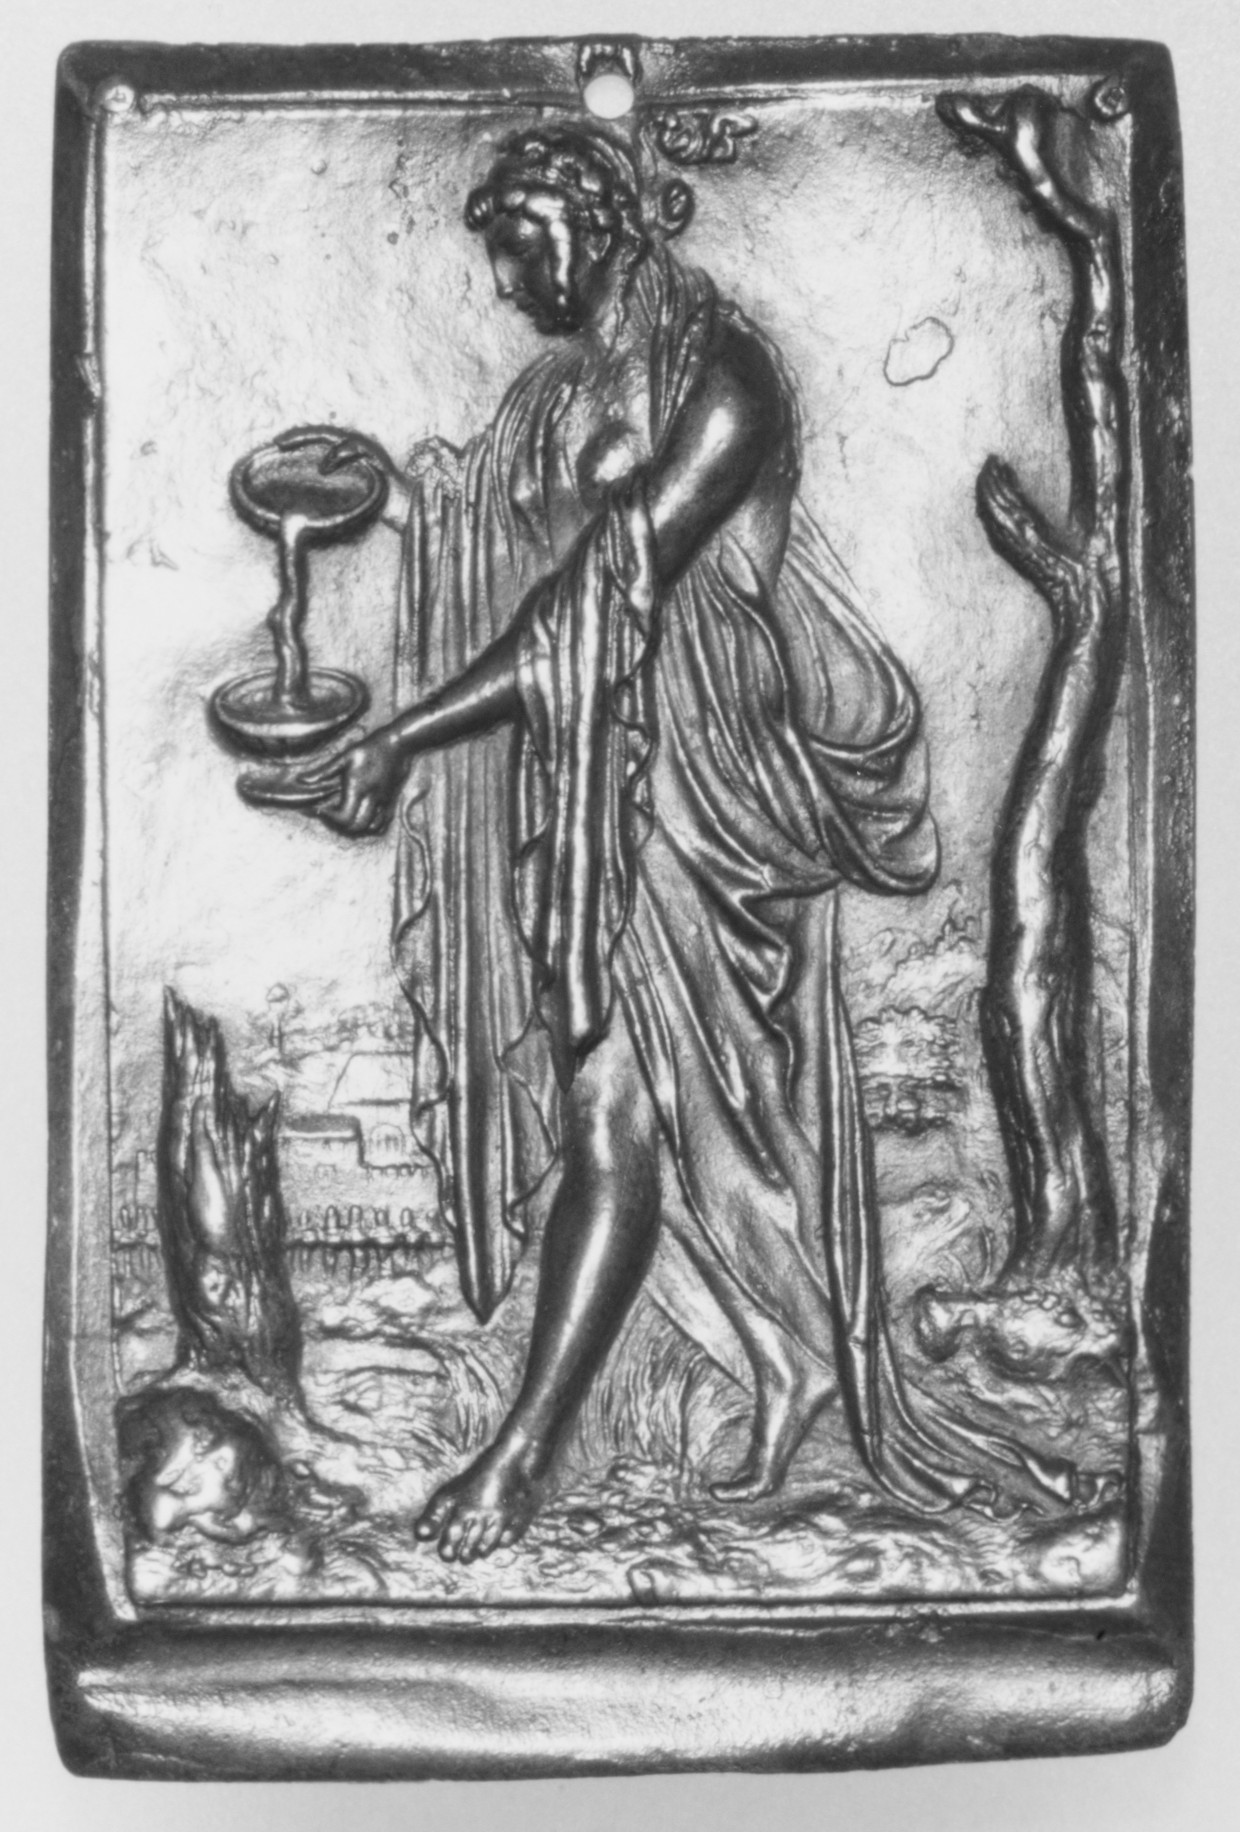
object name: plaquette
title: Temperance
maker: peter flötner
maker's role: artist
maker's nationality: german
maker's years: 1485-1546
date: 1540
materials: bronze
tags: women